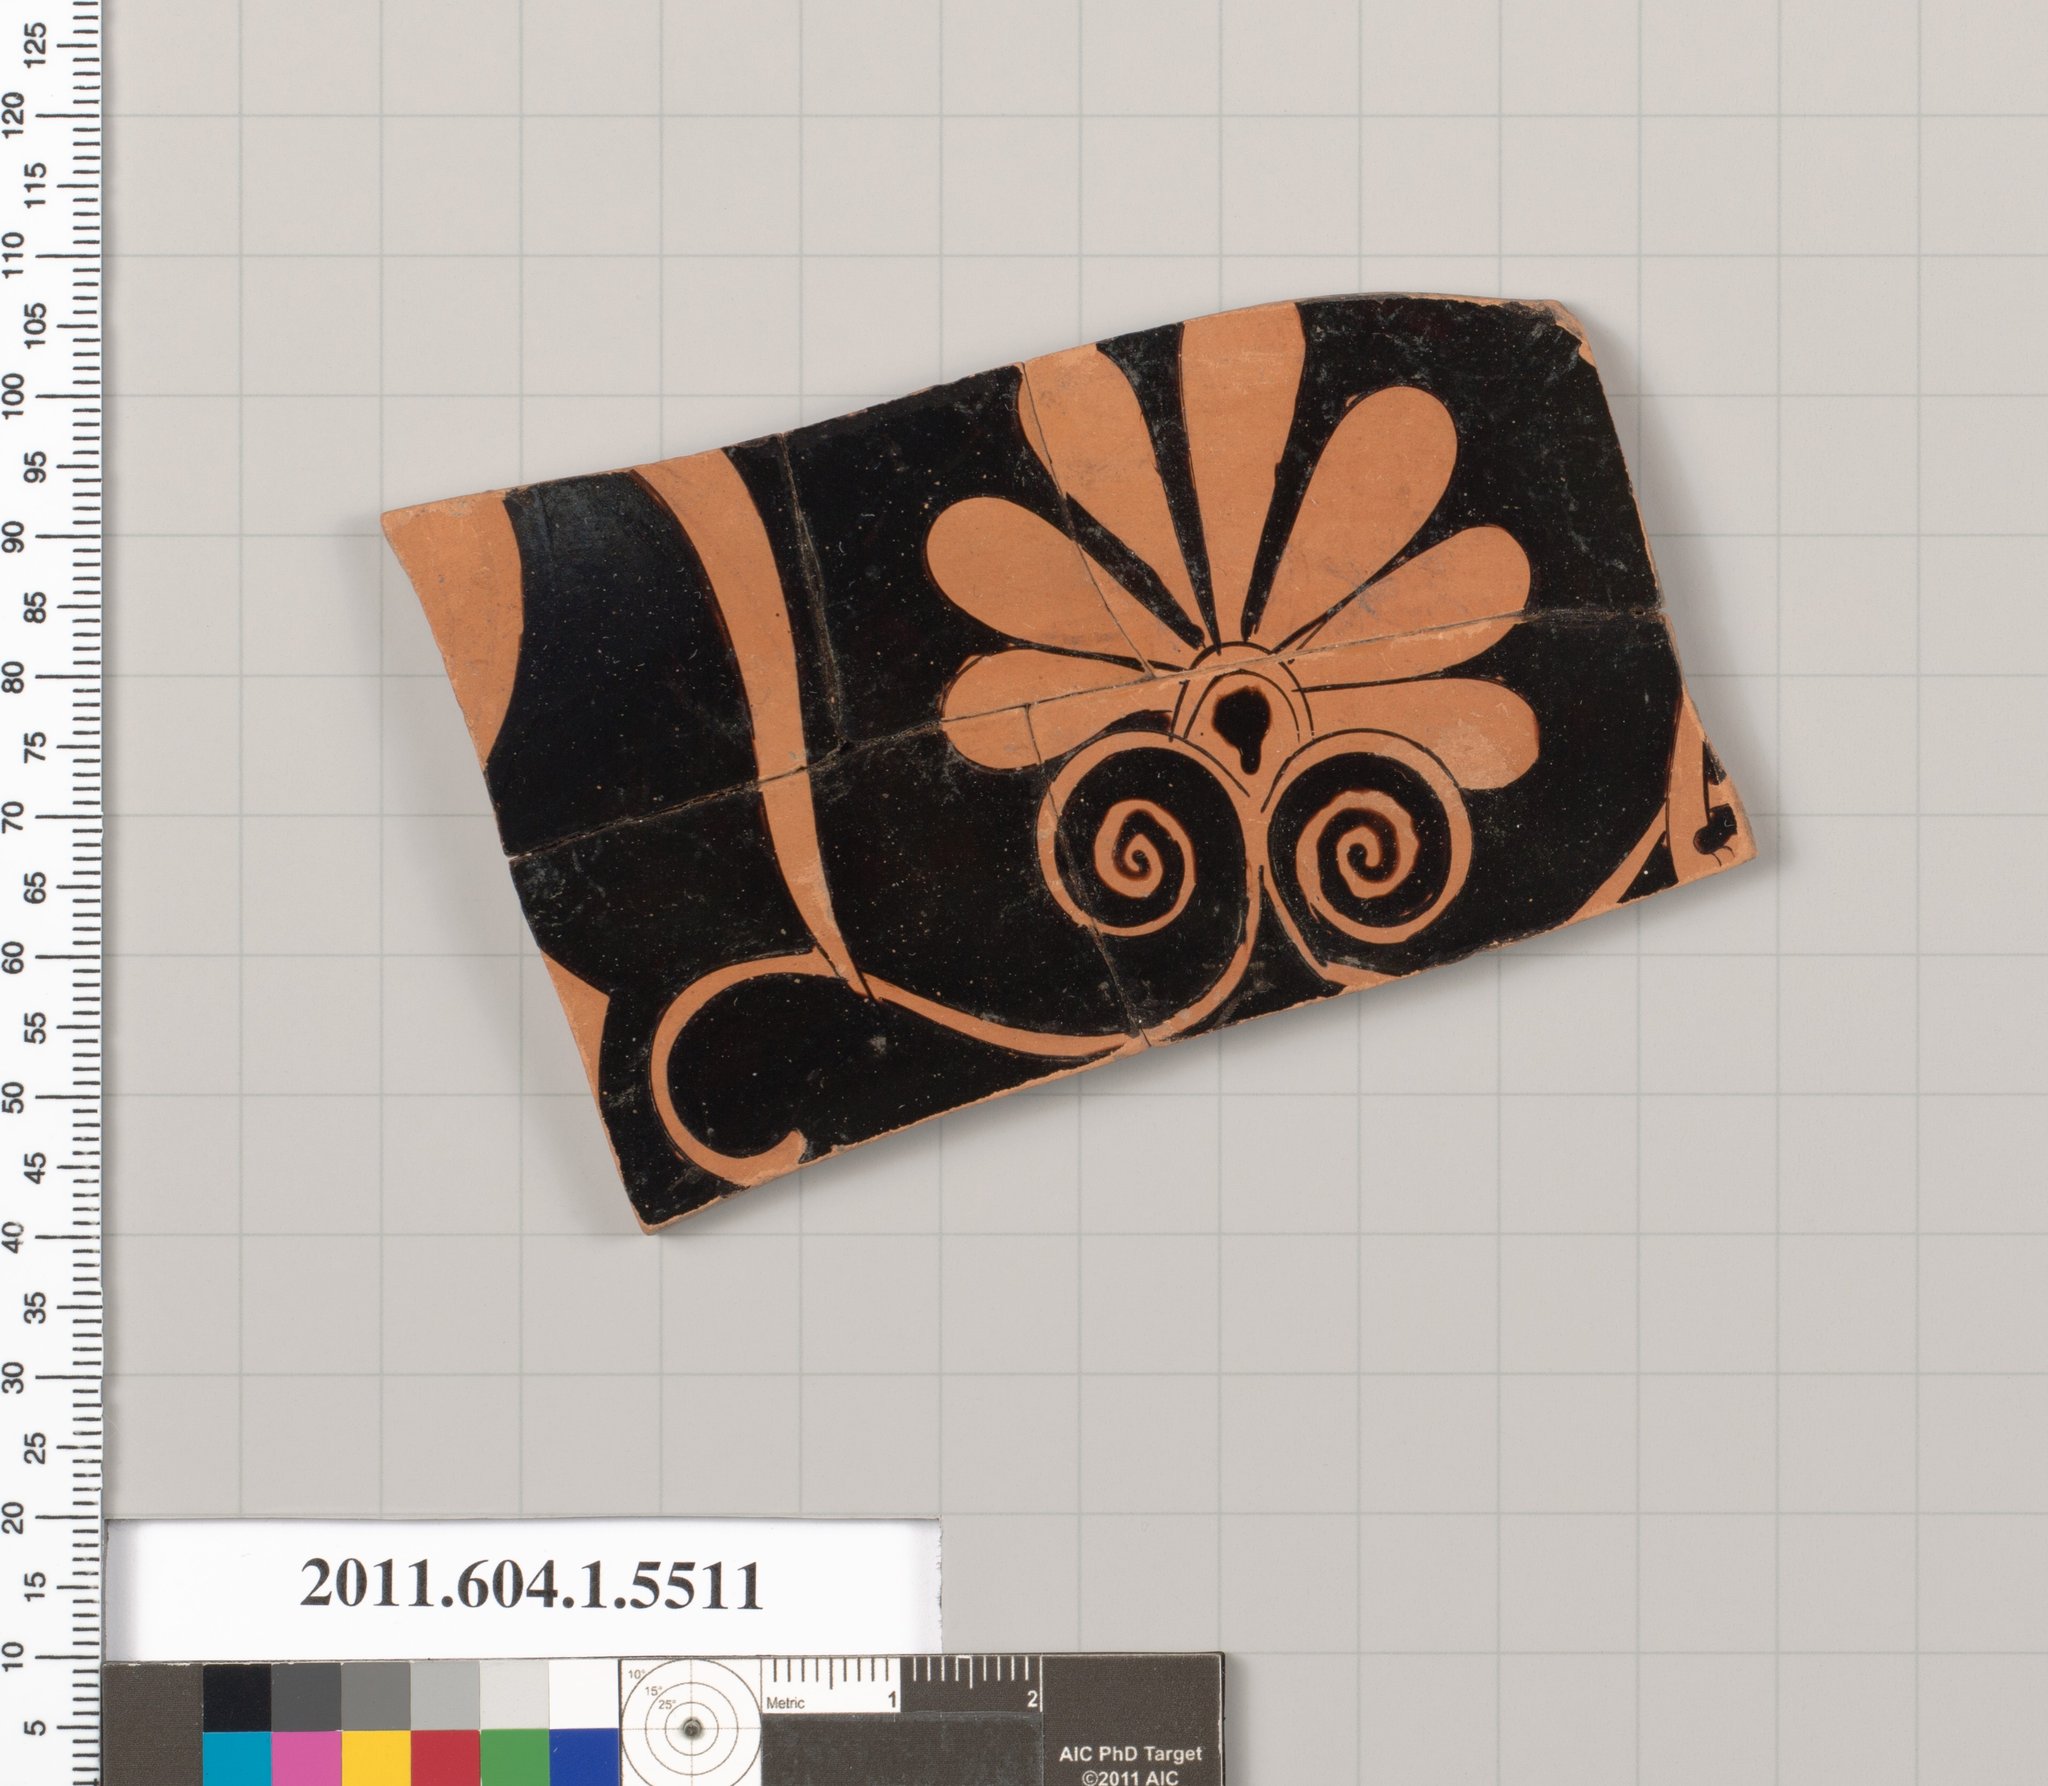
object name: kylix fragment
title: Terracotta fragment of a kylix (drinking cup)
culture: greek, attic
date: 520-500 BCE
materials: terracotta